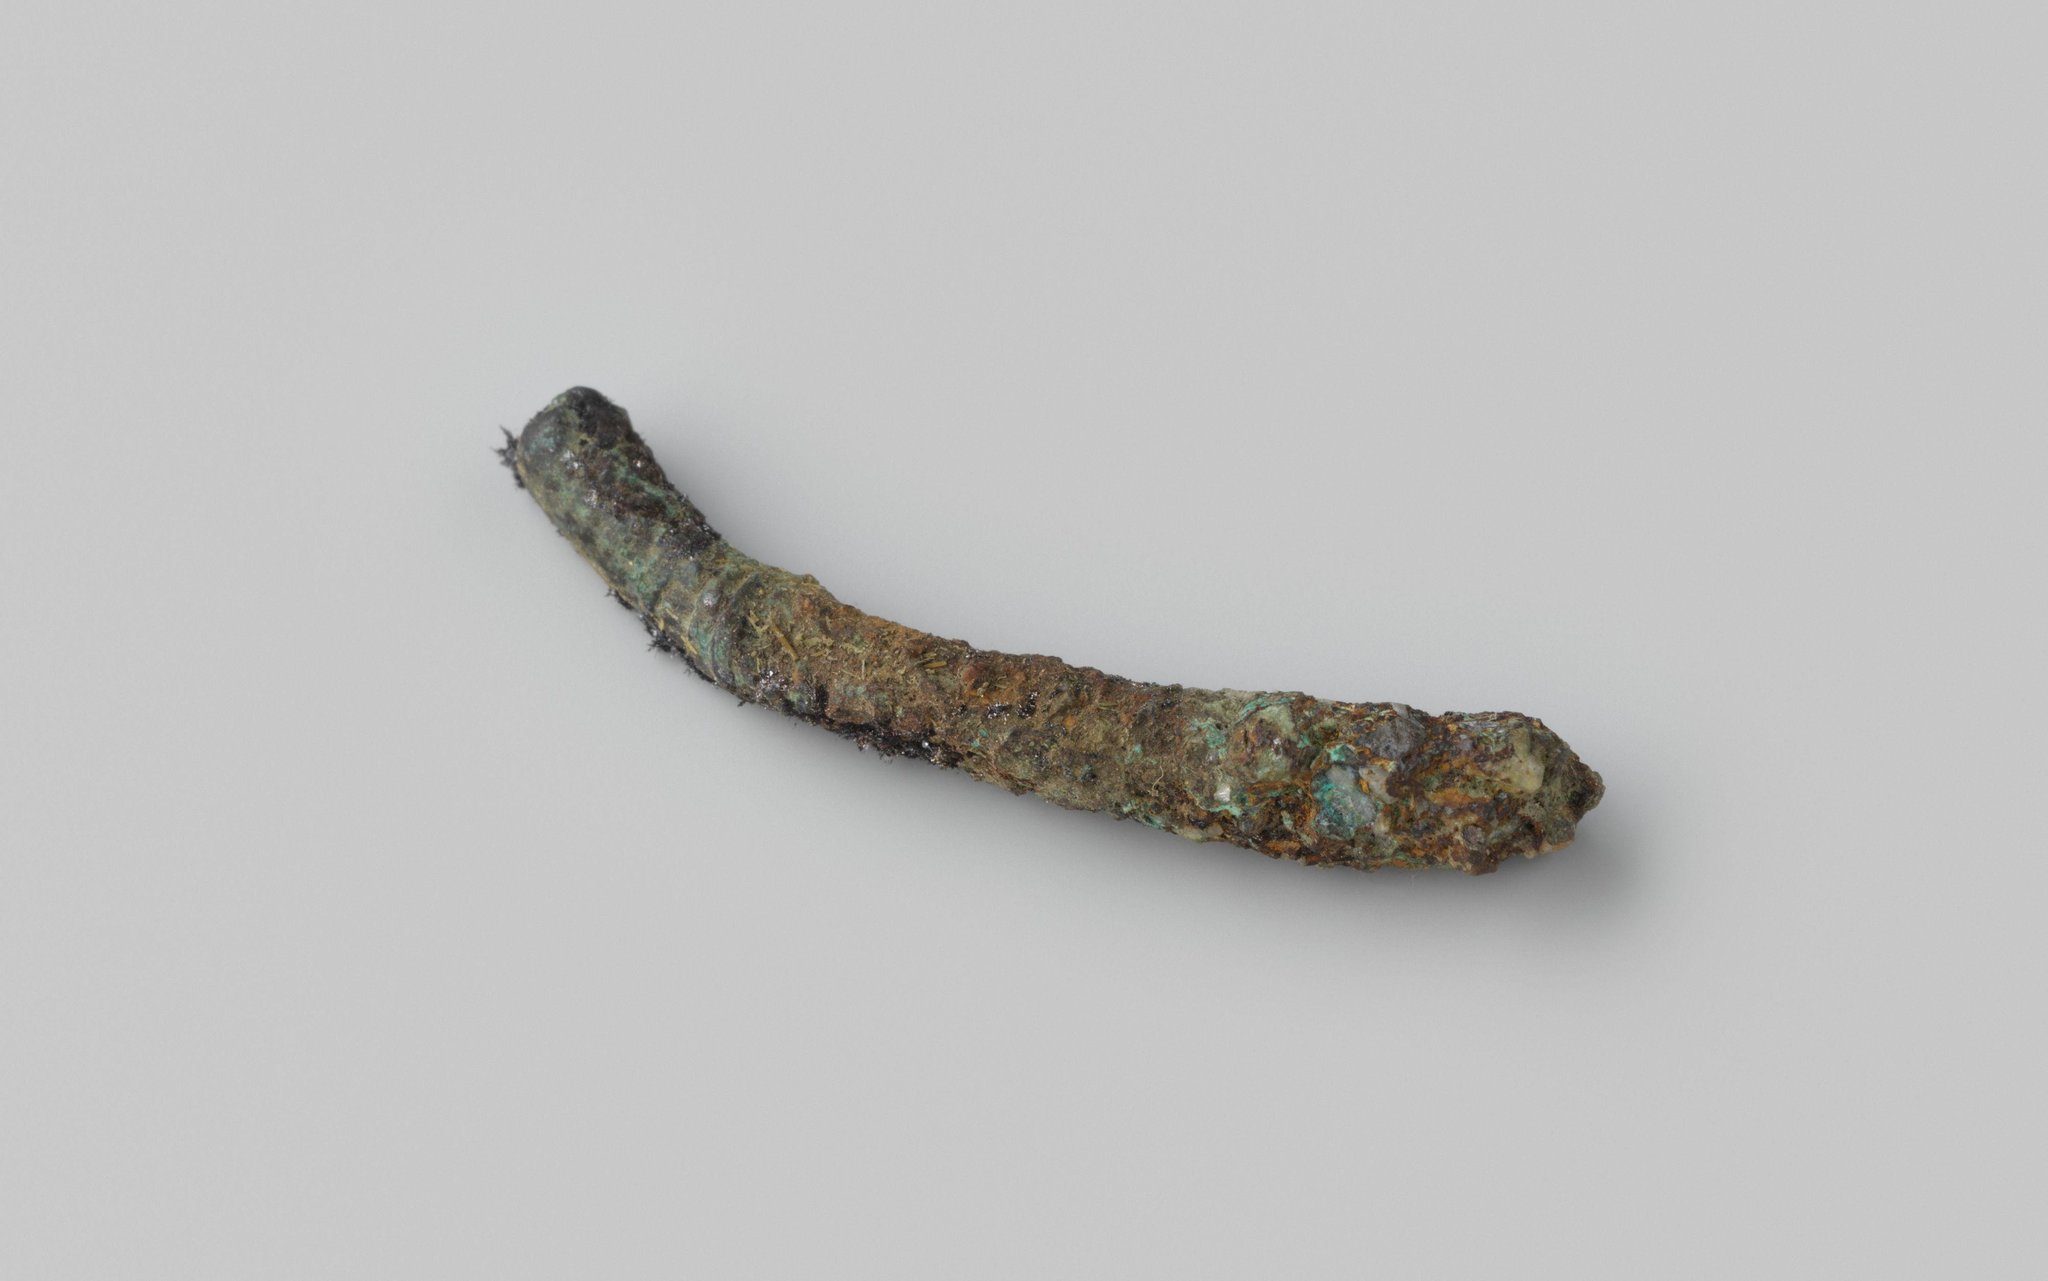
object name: bevestigingsmiddel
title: Bevestigingsmiddel afkomstig uit het wrak van de Oost-Indiëvaarder Hollandia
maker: Anonymous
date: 1700-1743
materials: copper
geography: netherlands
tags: verenigde oostindische compagnie, hollandia (schip)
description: Means of fitting, unspecified; fragm, corroded, sim. 80H3035.